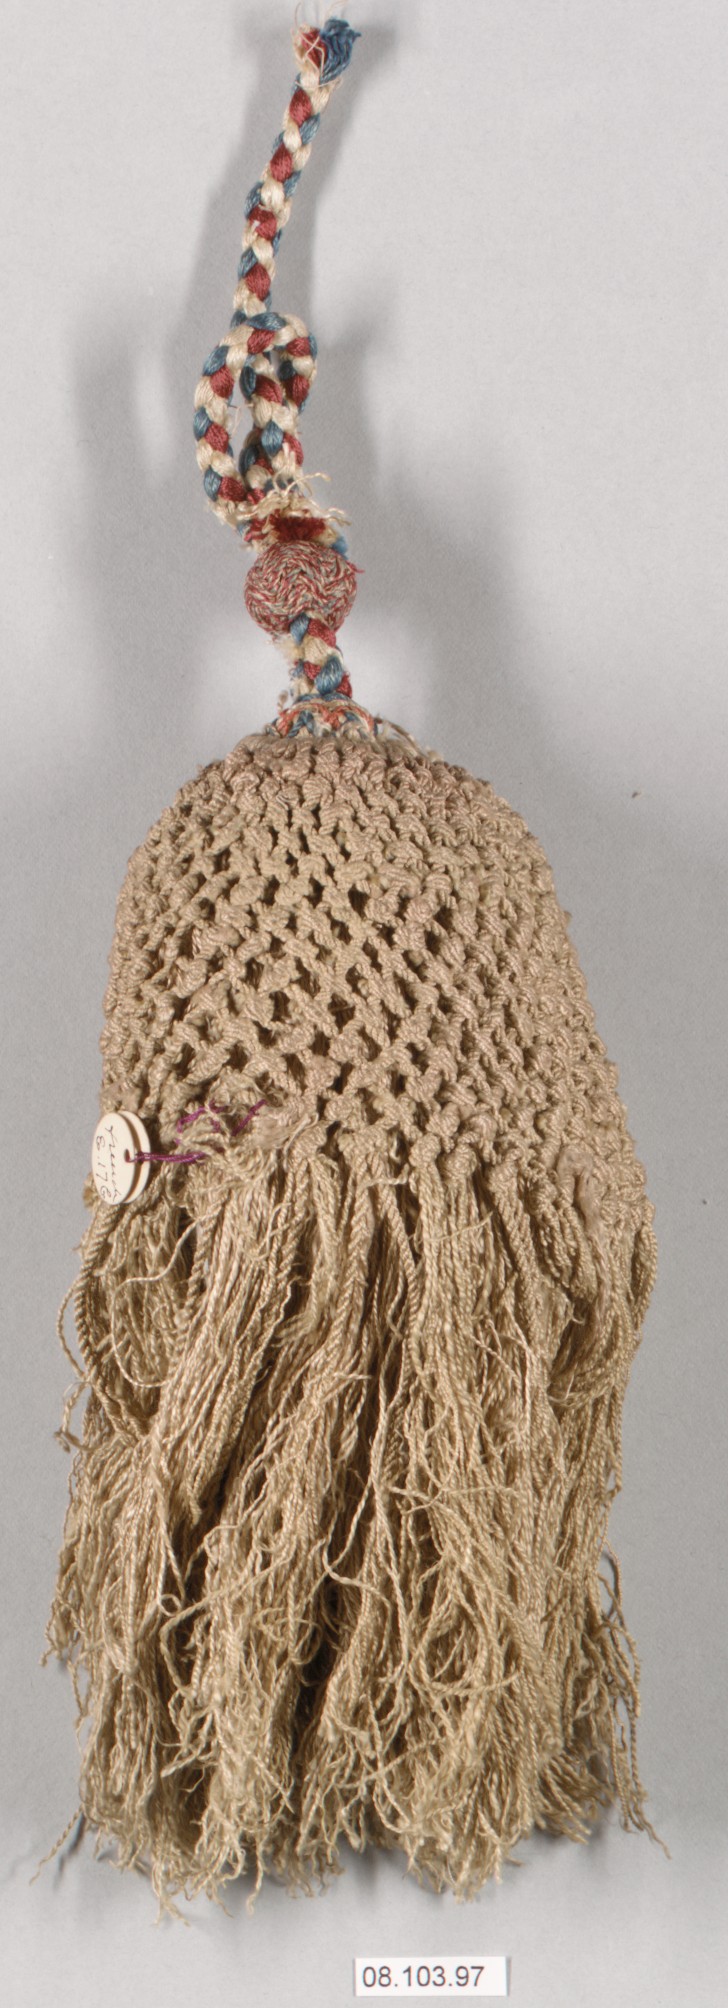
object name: tassel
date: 1601-1633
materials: silk